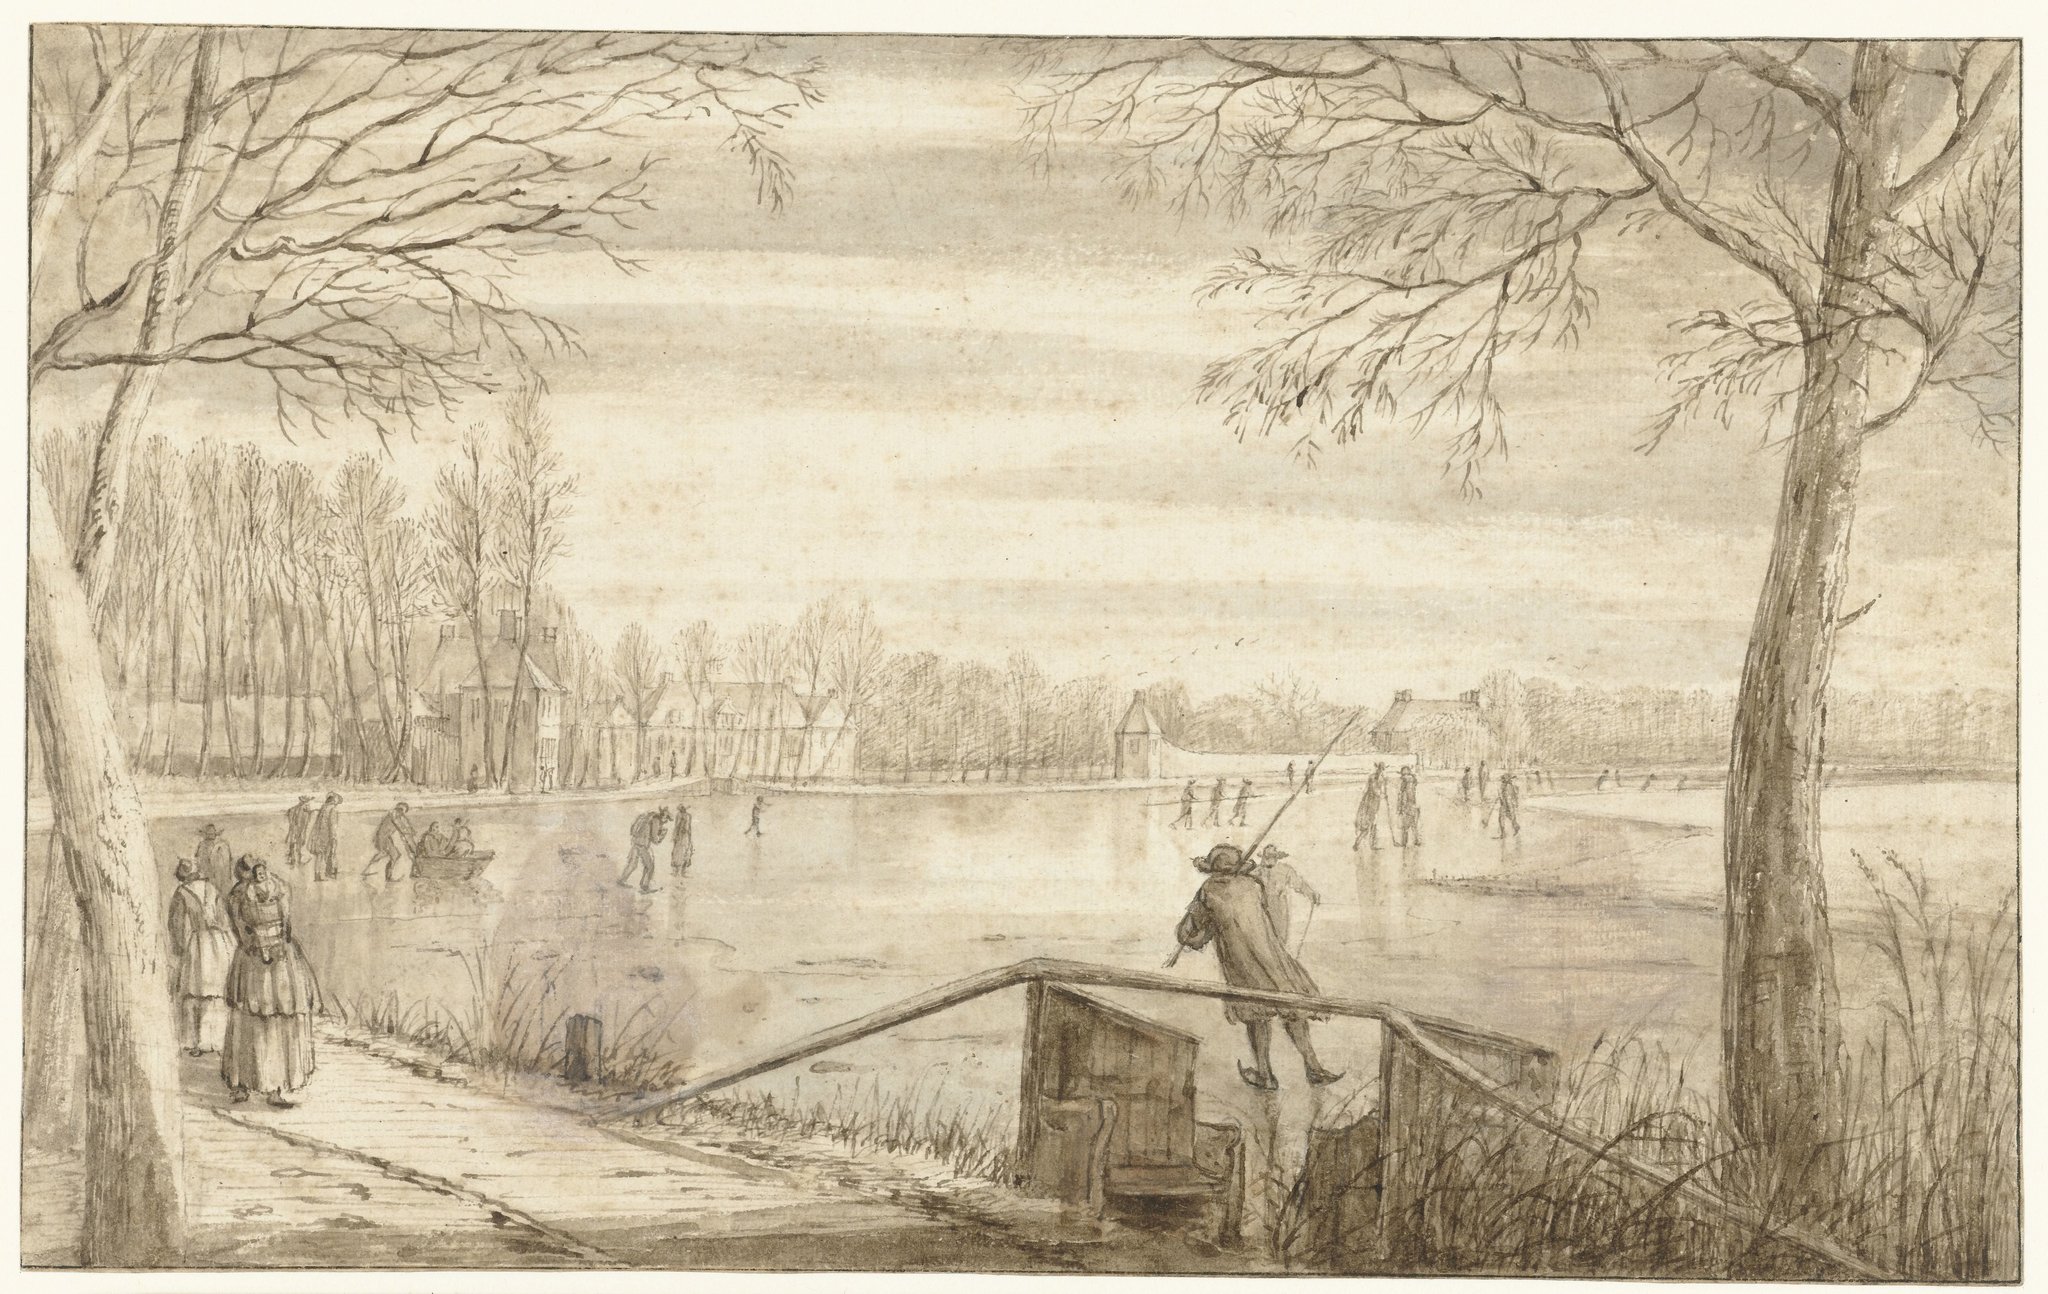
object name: drawing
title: Skaters on the River Vecht, near Maarssen, with the Estates of Daelwijck and Vechthoven in the Distance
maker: abraham rutgers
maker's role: draughtsman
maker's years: 1632-1699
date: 1682-1699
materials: graphite, ink, paper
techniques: brush, pen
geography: maarssen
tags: winter sports, ice ~ freezing weather, vecht